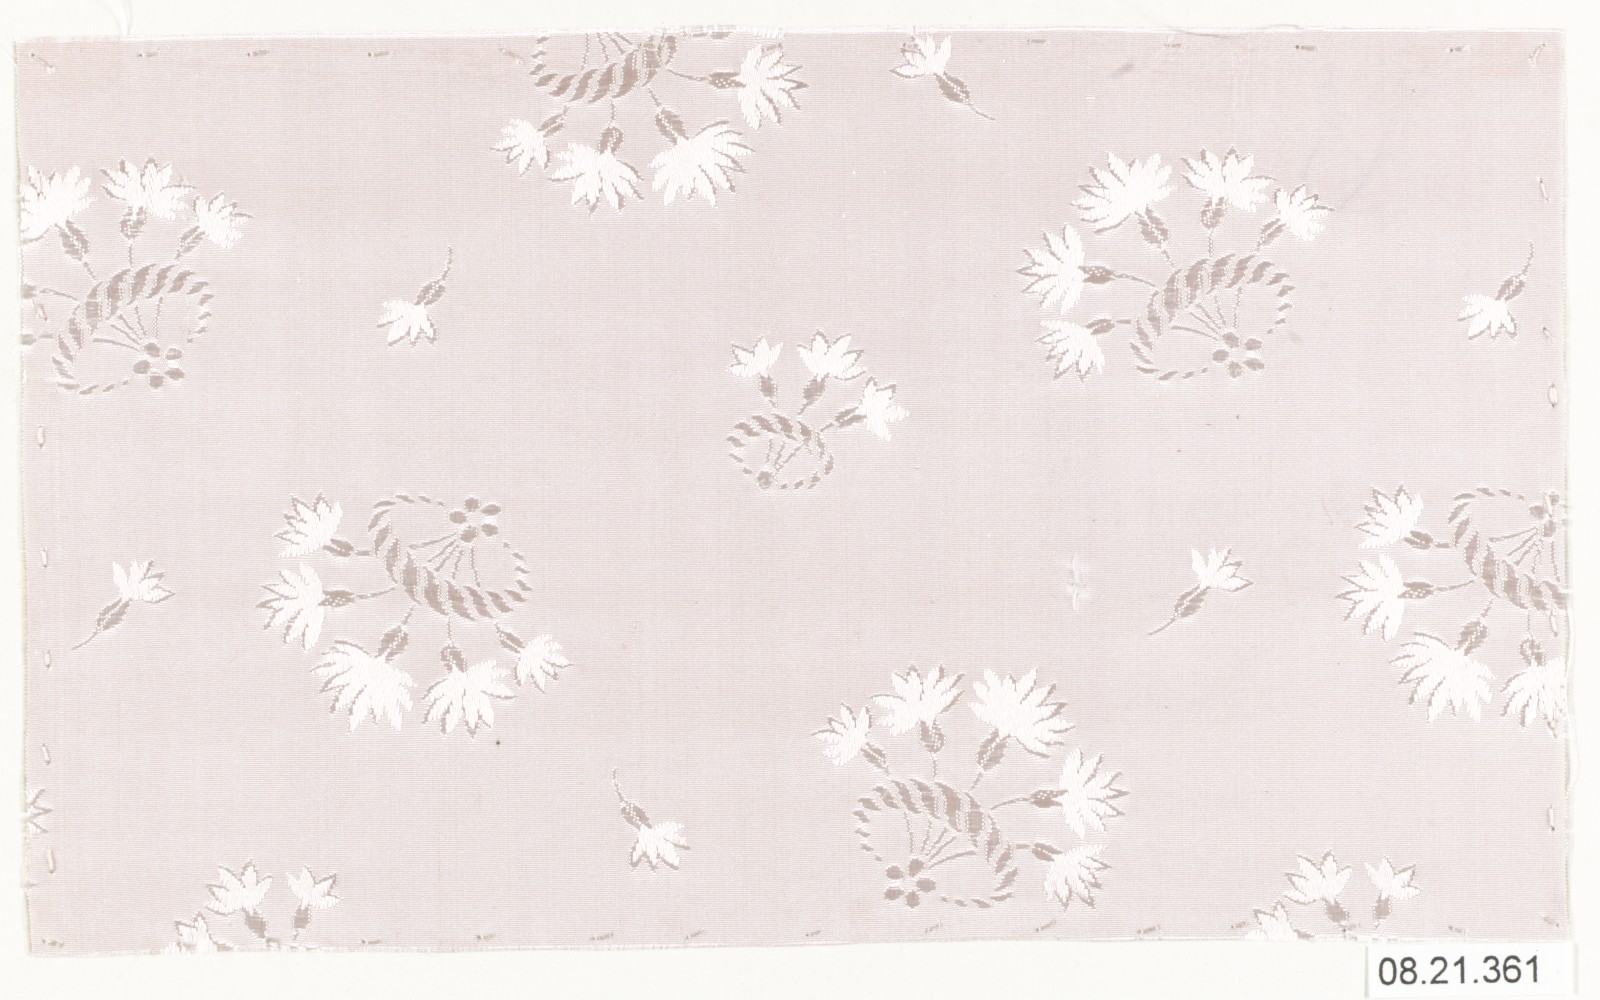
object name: textile sample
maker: Anonymous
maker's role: designer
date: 1900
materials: silk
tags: flowers